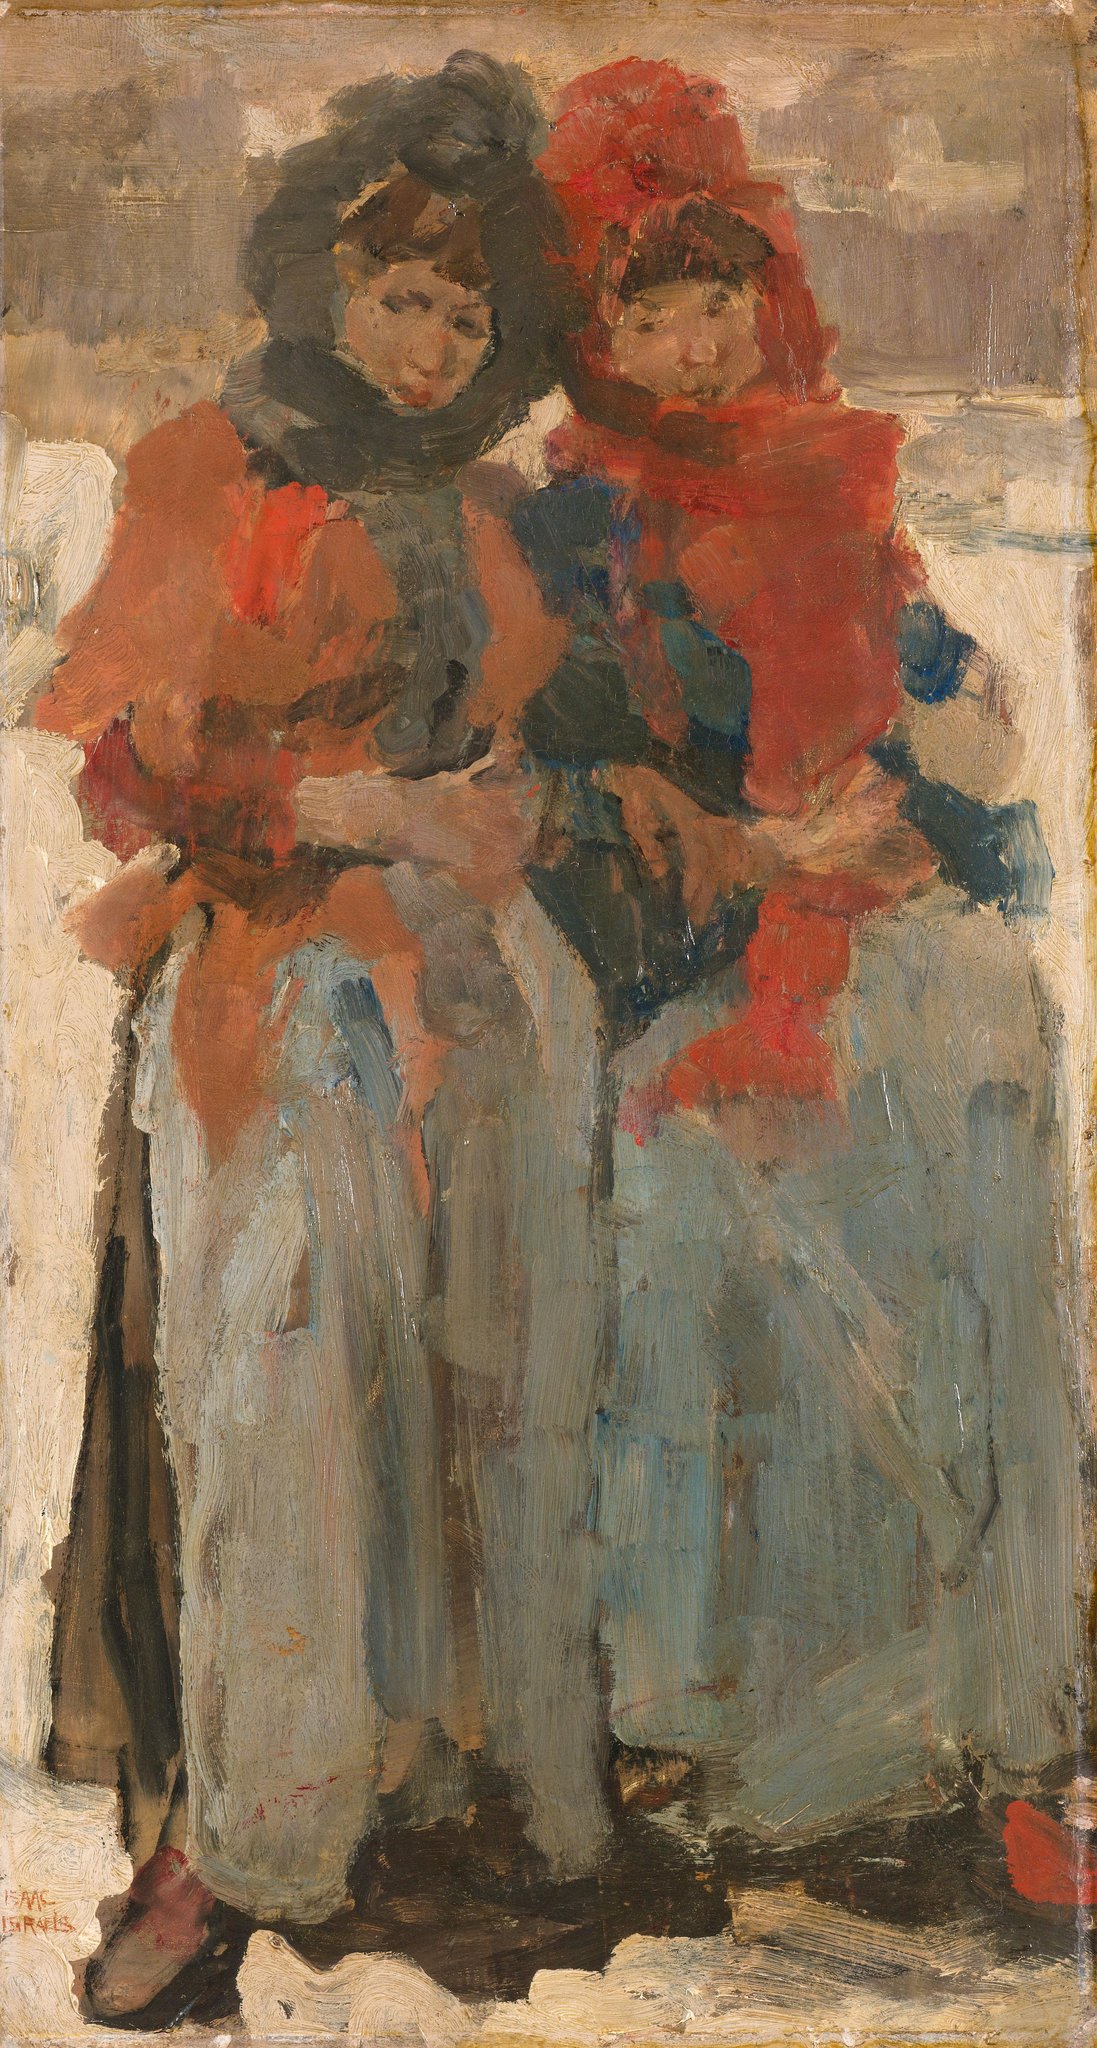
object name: painting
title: Two Girls in the Snow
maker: isaac israels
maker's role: draughtsman, painter, print maker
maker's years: 1865-1934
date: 1890-1894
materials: oil, panel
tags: adolescent, young woman, maiden, snow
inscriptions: signature: ‘Isaac Israels’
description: An everday scene in Amsterdam in the winter: two warmly dressed factory workers or studio models. Israels painted them as if, during their break, they had briefly, hesitatingly, stopped before him. However, appearances can be deceptive. The pose of both women is carefully considered, and the black and red passages of their shawls and coats are contrasted to create a well-balanced composition, despite looking like the record of a fleeting moment.